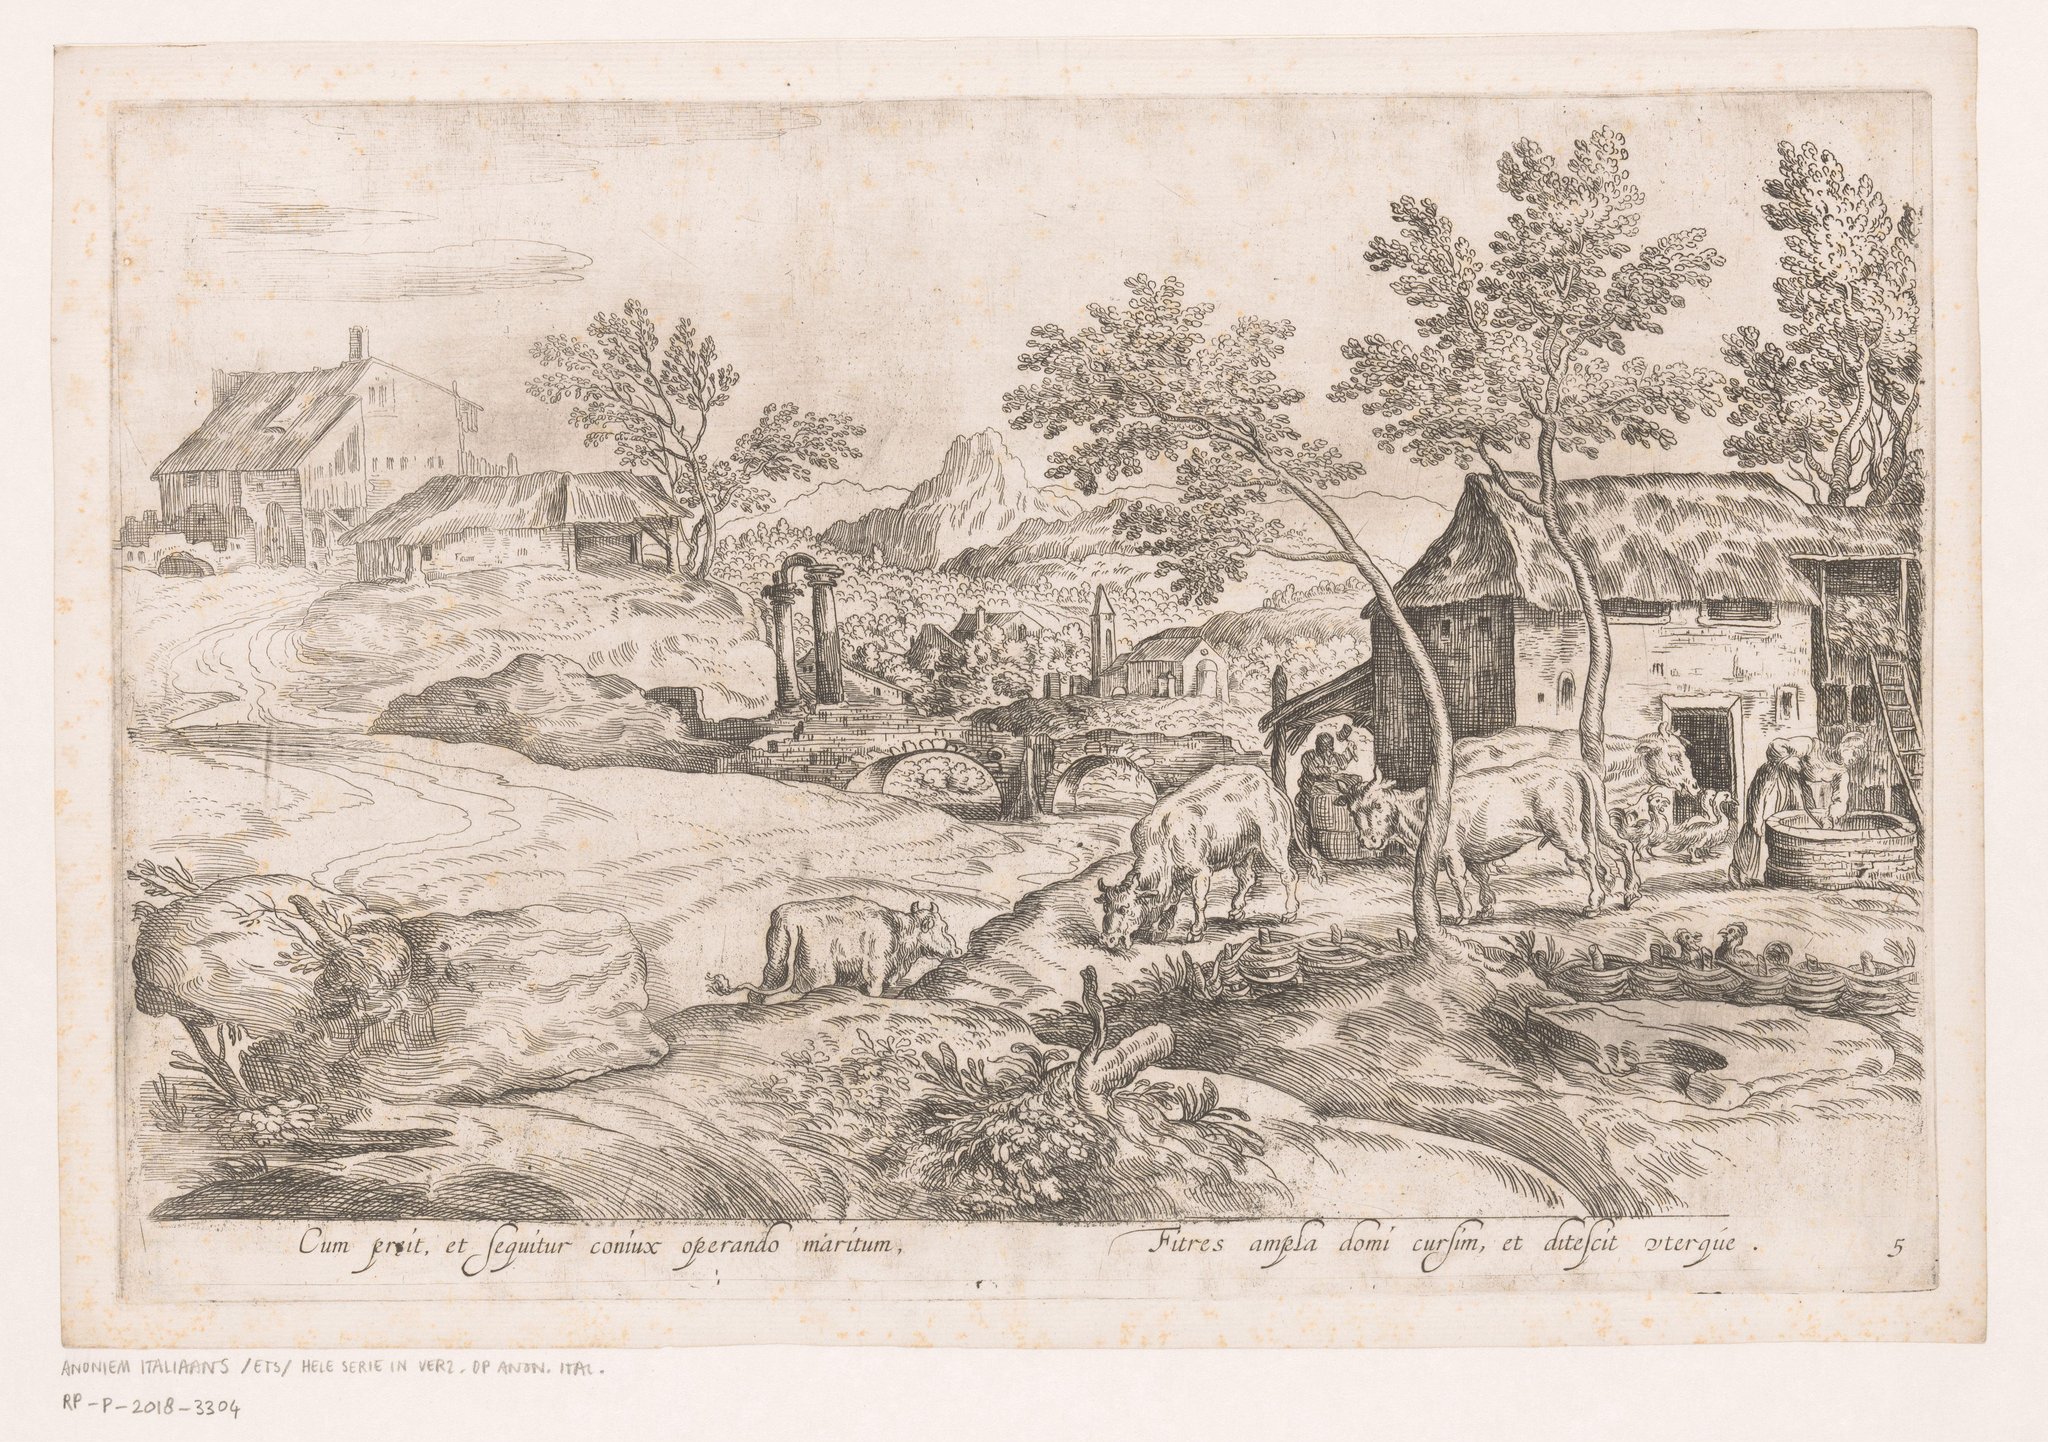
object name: print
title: Landschap met een boerderij met koeien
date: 1634-1679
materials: paper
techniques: etching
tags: well, cow, landscapes in the temperate zone, farm (building)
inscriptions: collector's mark: Lugt 2228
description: Maakt deel uit van een 24-delige serie naar tekeningen van landschappen toegeschreven aan Campagnola, of de school van Campagnola (zie British Museum, inv.nr. S.6782). Plaat twee uit de serie betreft waarschijnlijk echter een ontwerp van Titaan (zie British Museum, inv.nr. S.6783).